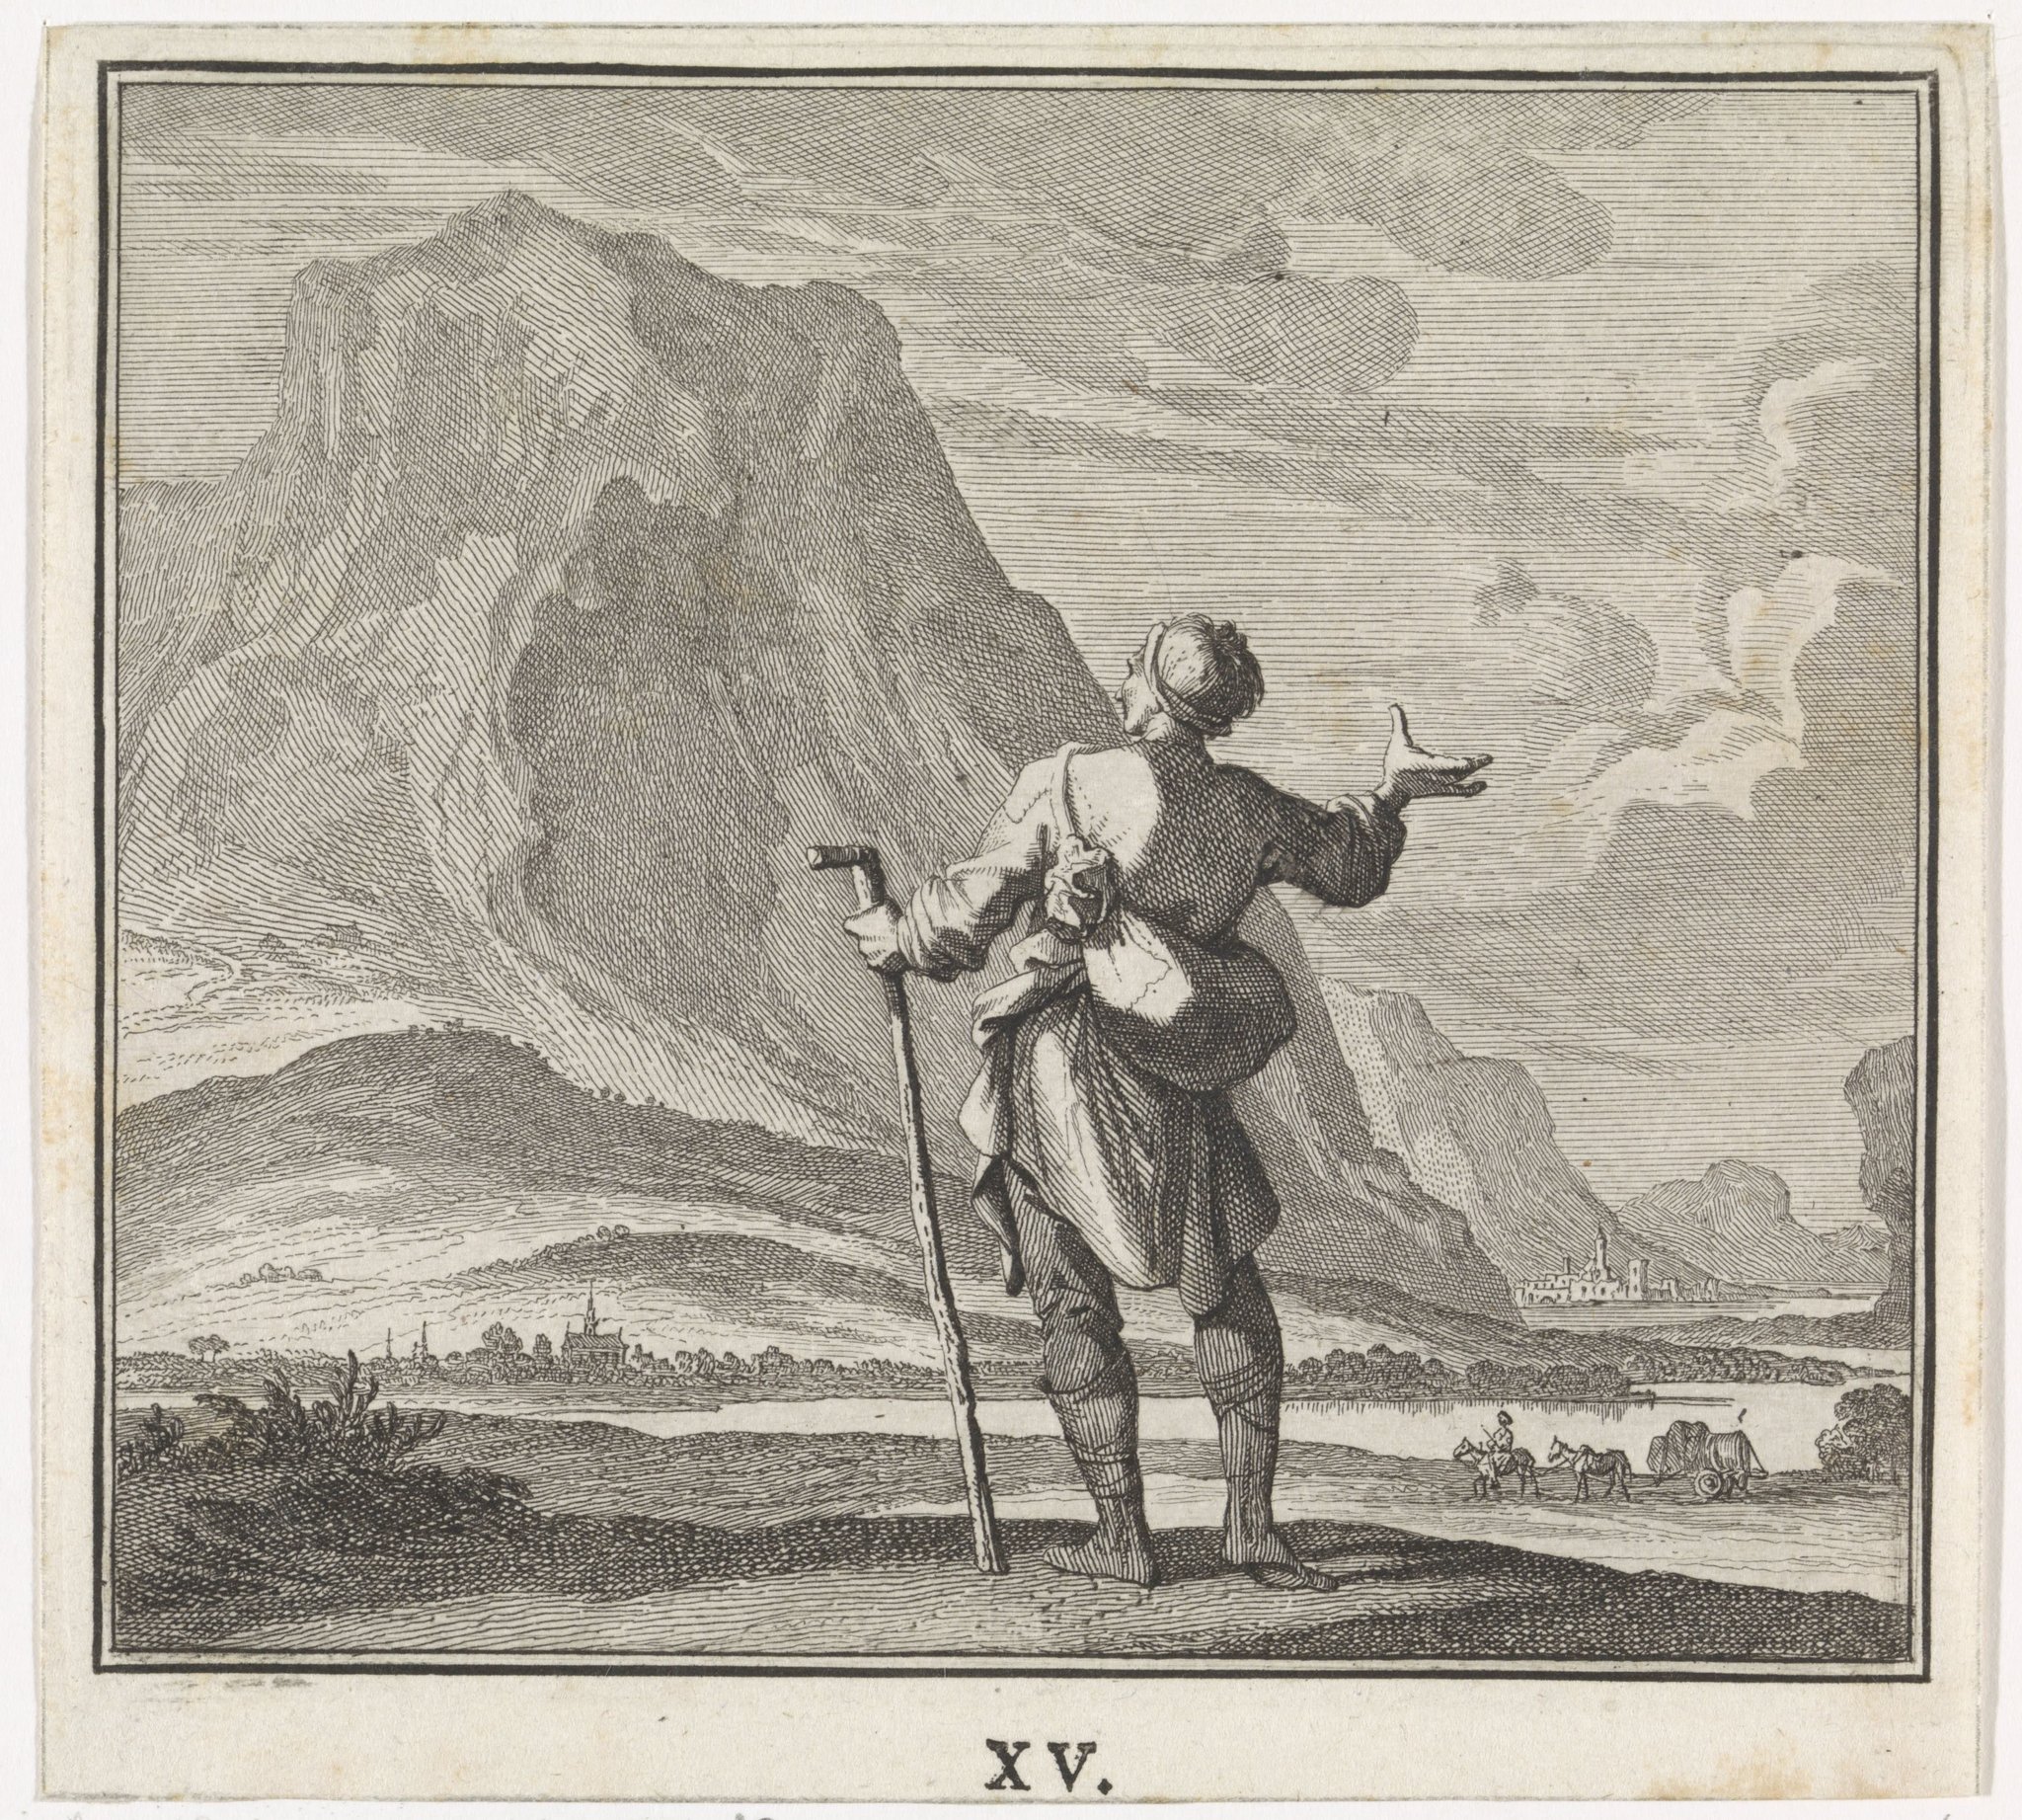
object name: book illustration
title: Berglandschap met wandelaar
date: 1700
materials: paper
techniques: etching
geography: nuremberg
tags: river, mountains, abstract ideas and concepts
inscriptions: collector's mark: Lugt 2228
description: Boekillustratie voor Weigel, Christoph. Ethica Naturalis seu Documenta Moralia e Variis rerum Naturalium proprietatibus Virtutum Vitiorumq symbolicis imaginibus collecta. Neurenberg: Christoph Weigel: c. 1700.